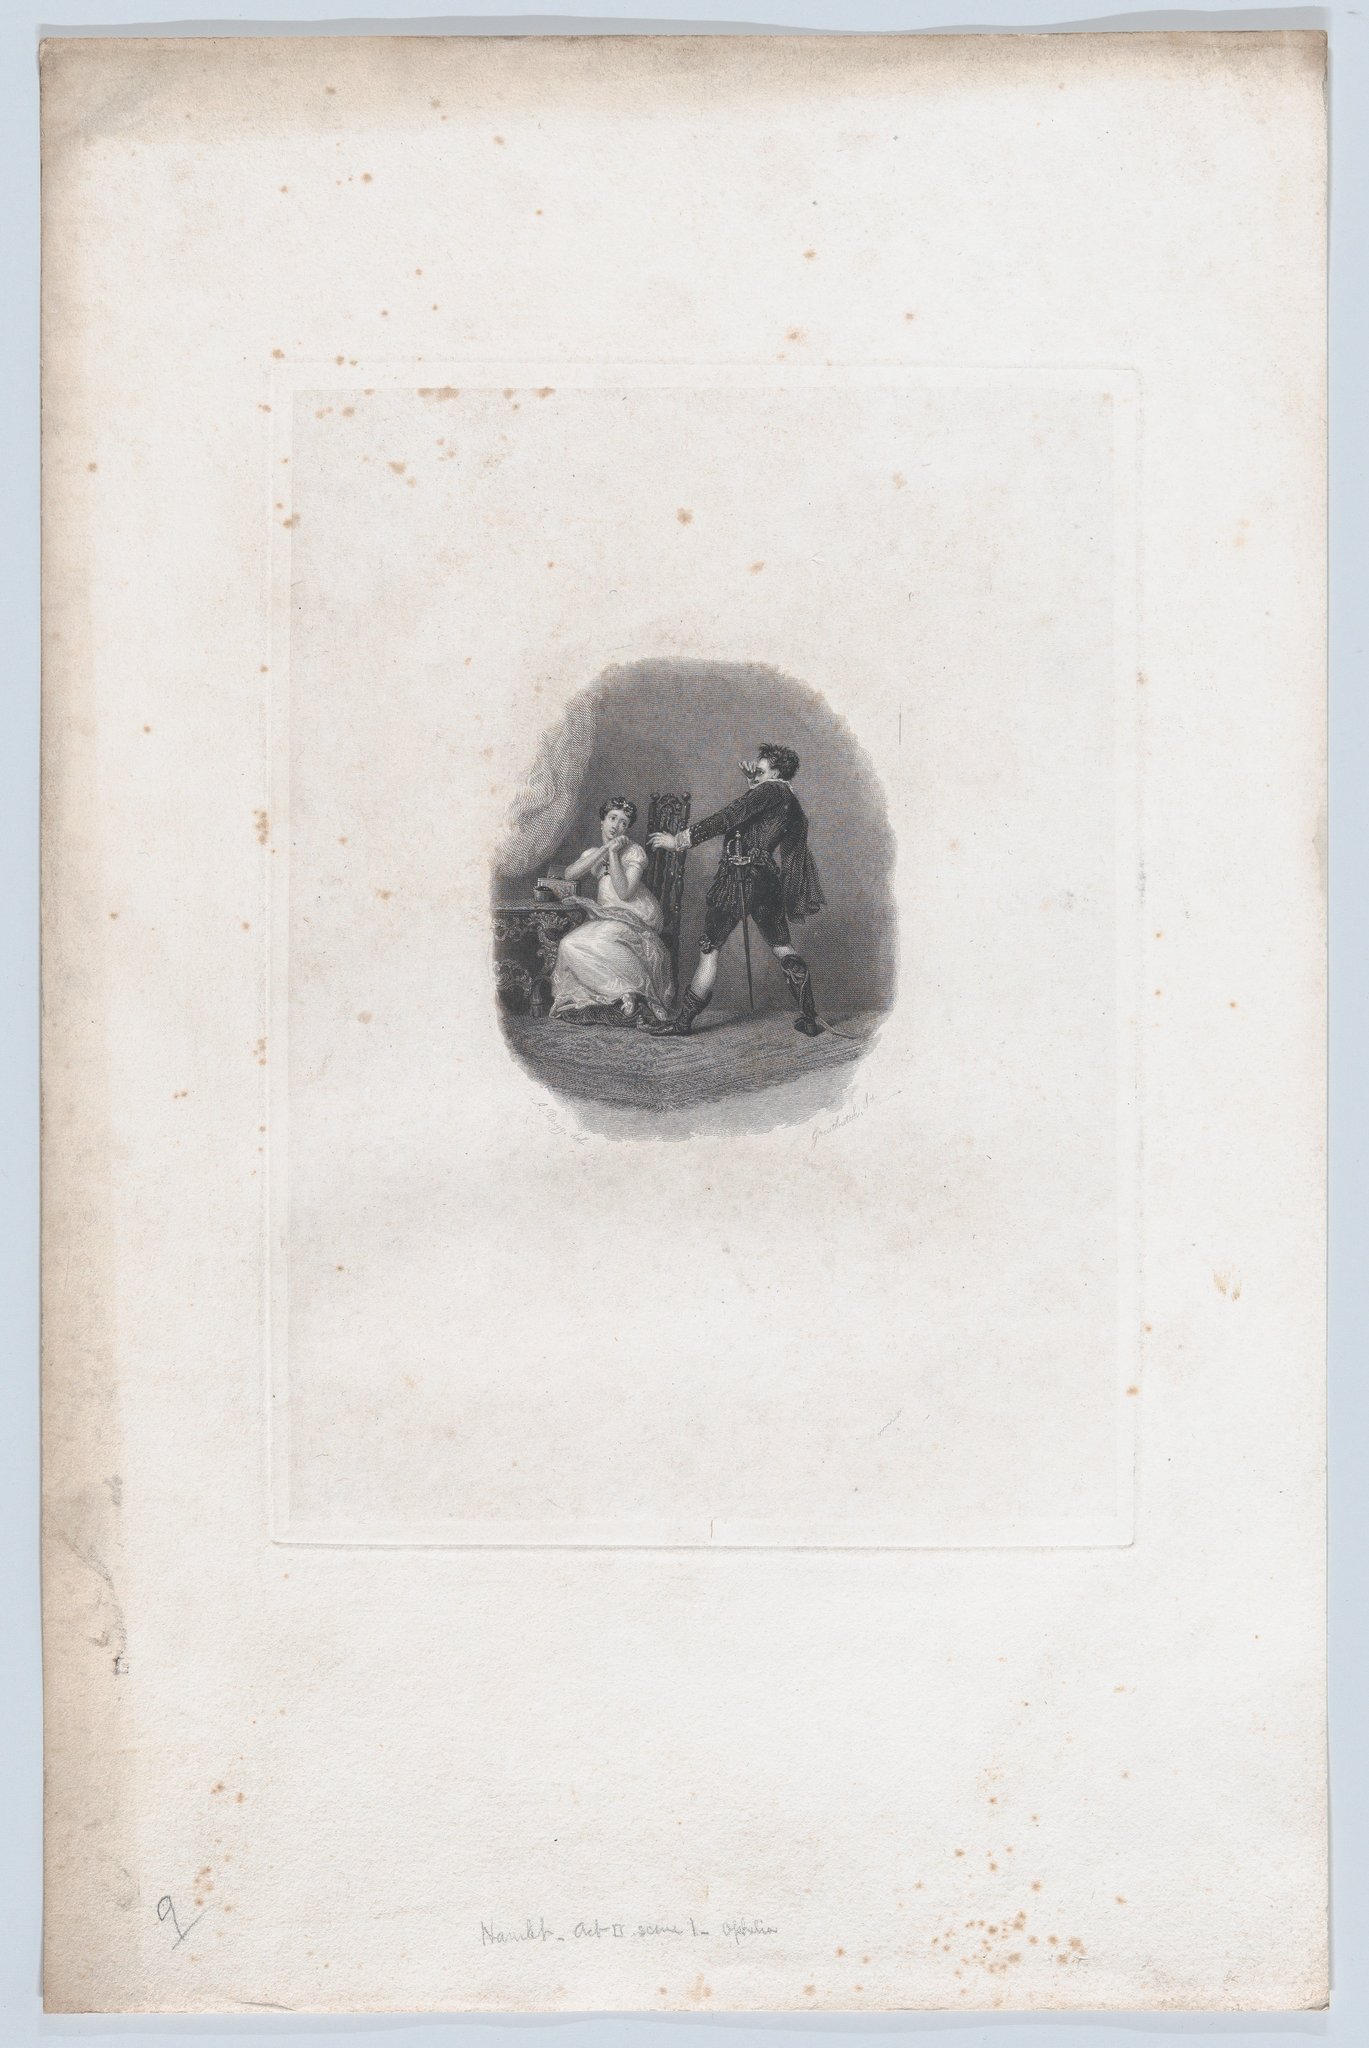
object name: print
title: Hamlet and Ophelia (Shakespeare, Hamlet, Act II, Scene I)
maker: william greatbach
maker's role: engraver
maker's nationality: british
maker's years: 1802-1894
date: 1825-1826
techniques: printmaking, engraving, etching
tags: shakespeare,men,women